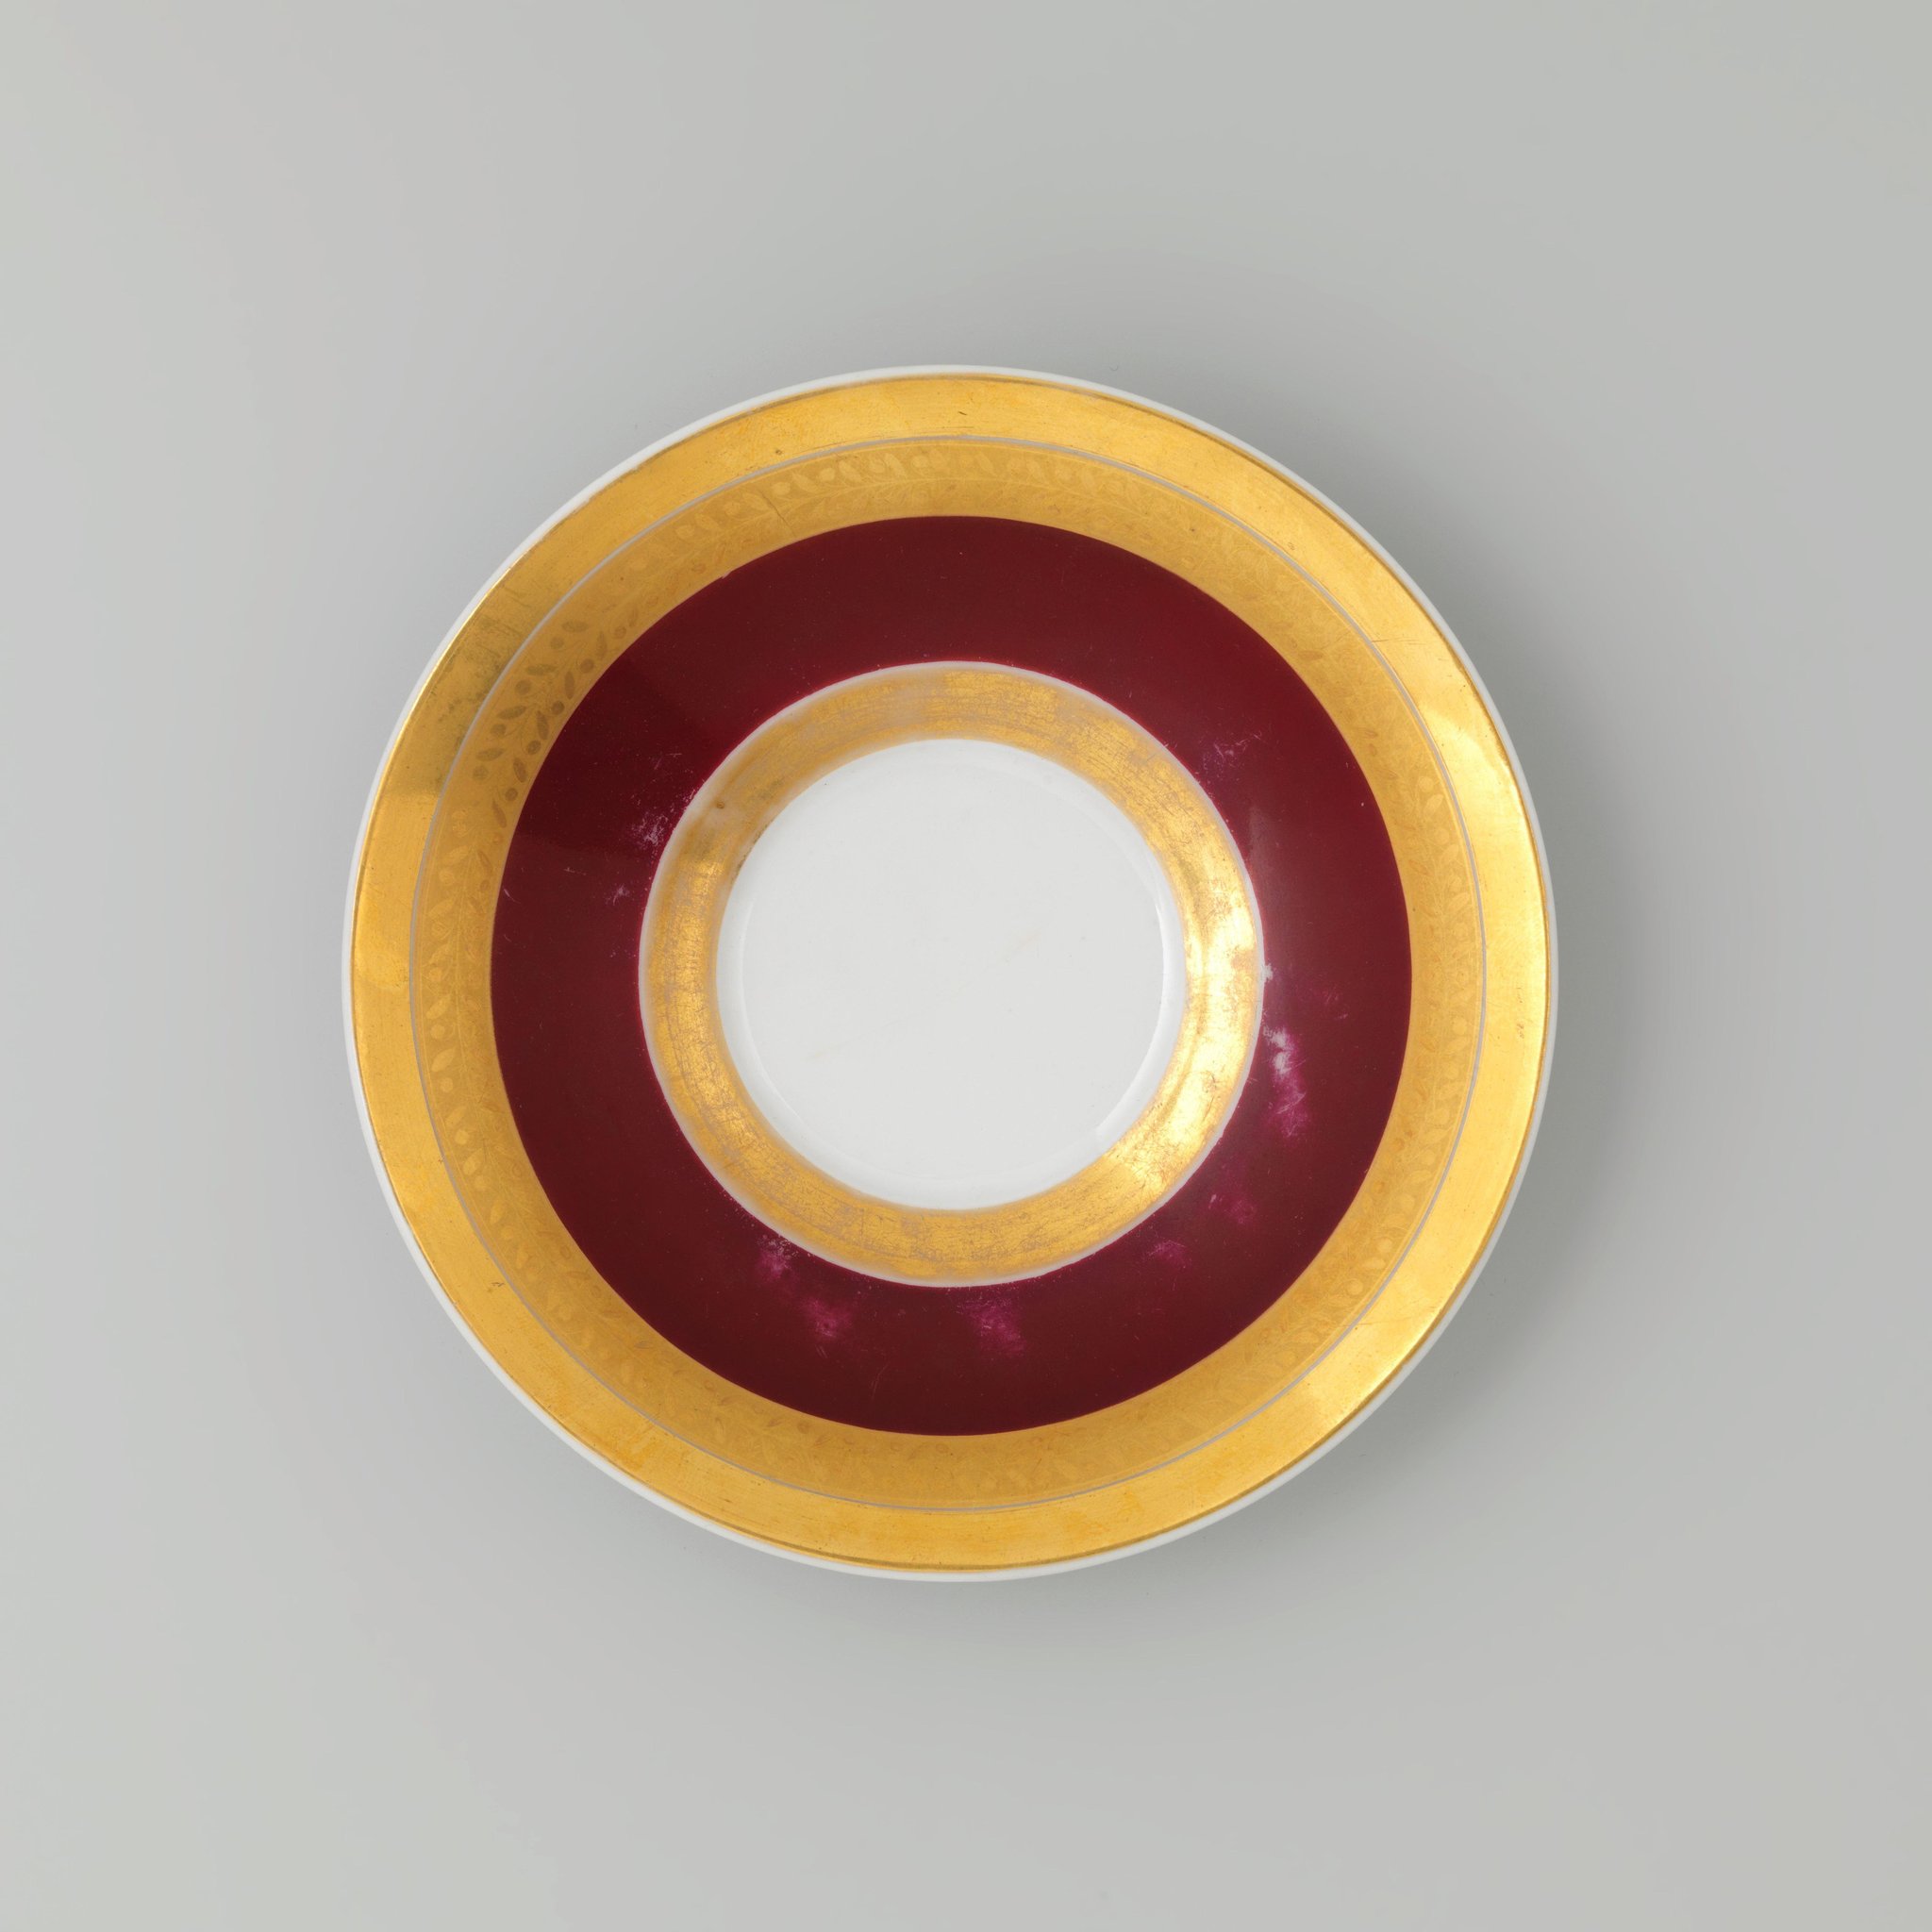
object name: platter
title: Saucer with gold borders on a red ground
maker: Anonymous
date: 1800-1824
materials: glaze, gold, paint, porcelain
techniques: firing, forming, gilding, turning, vitrification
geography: france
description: Schotel van porselein, bedekt op het glazuur met rood en goud. De wand en rand zijn bedekt met banden van rood en goud, waarbij op de rand éé een bloemrank heeft. Gouden lijn op de voet. Empire.